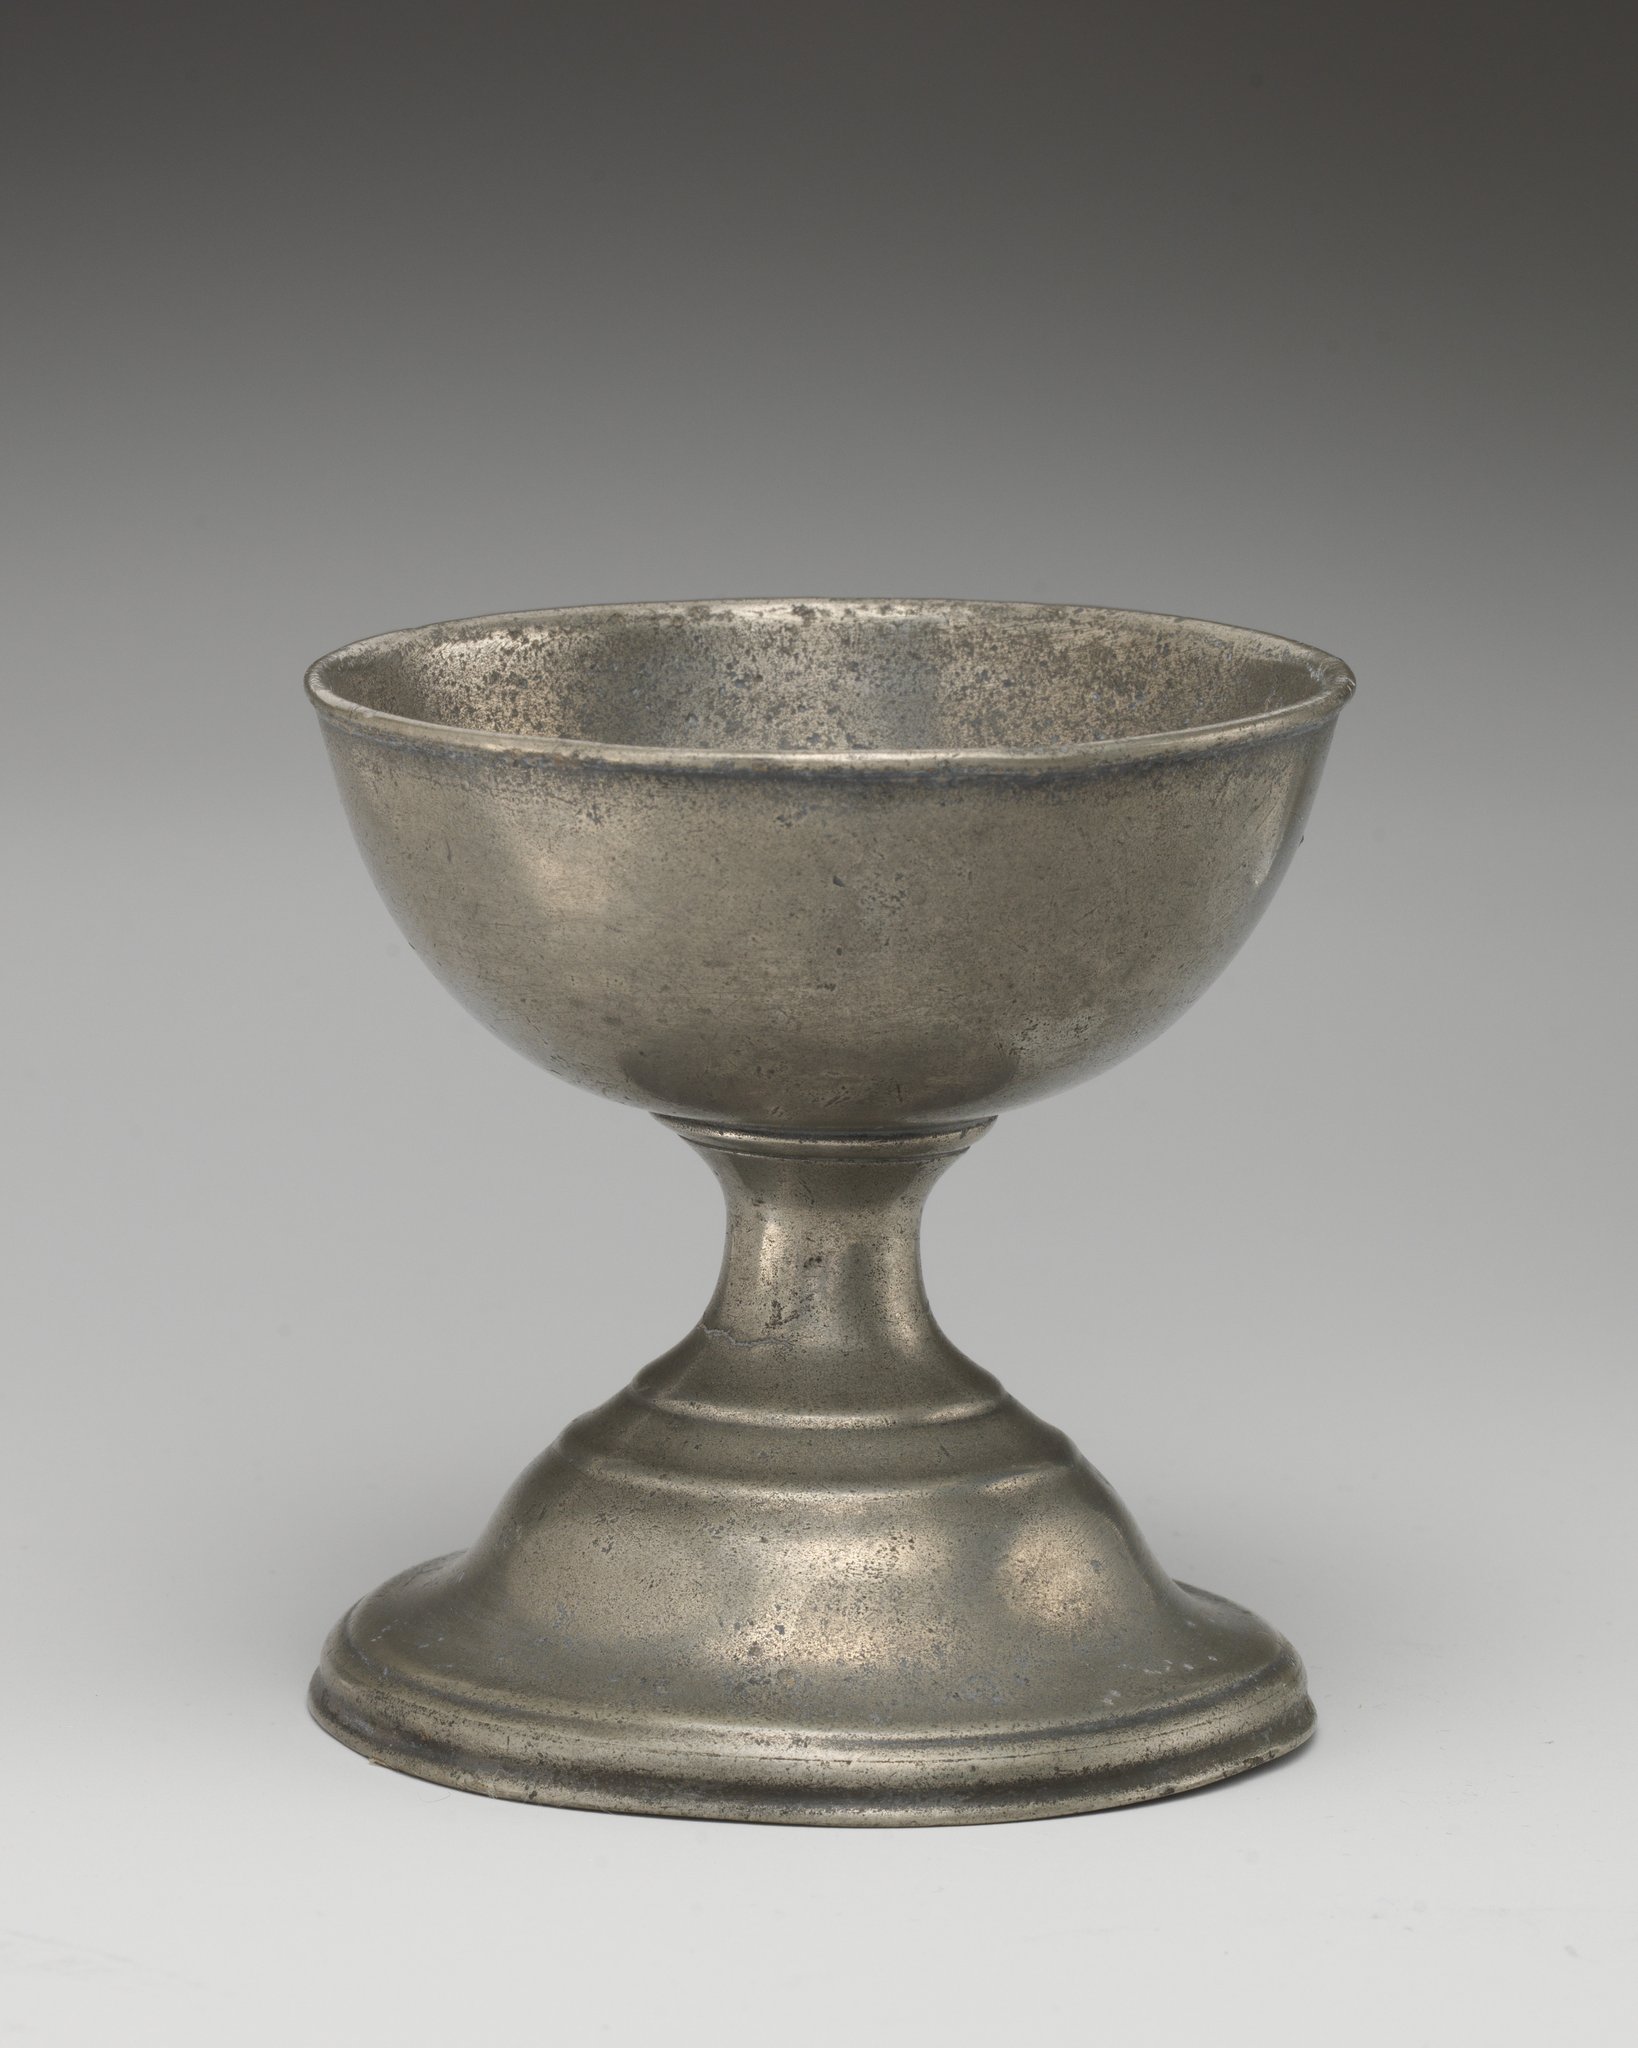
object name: salt cup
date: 1701-1800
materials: pewter